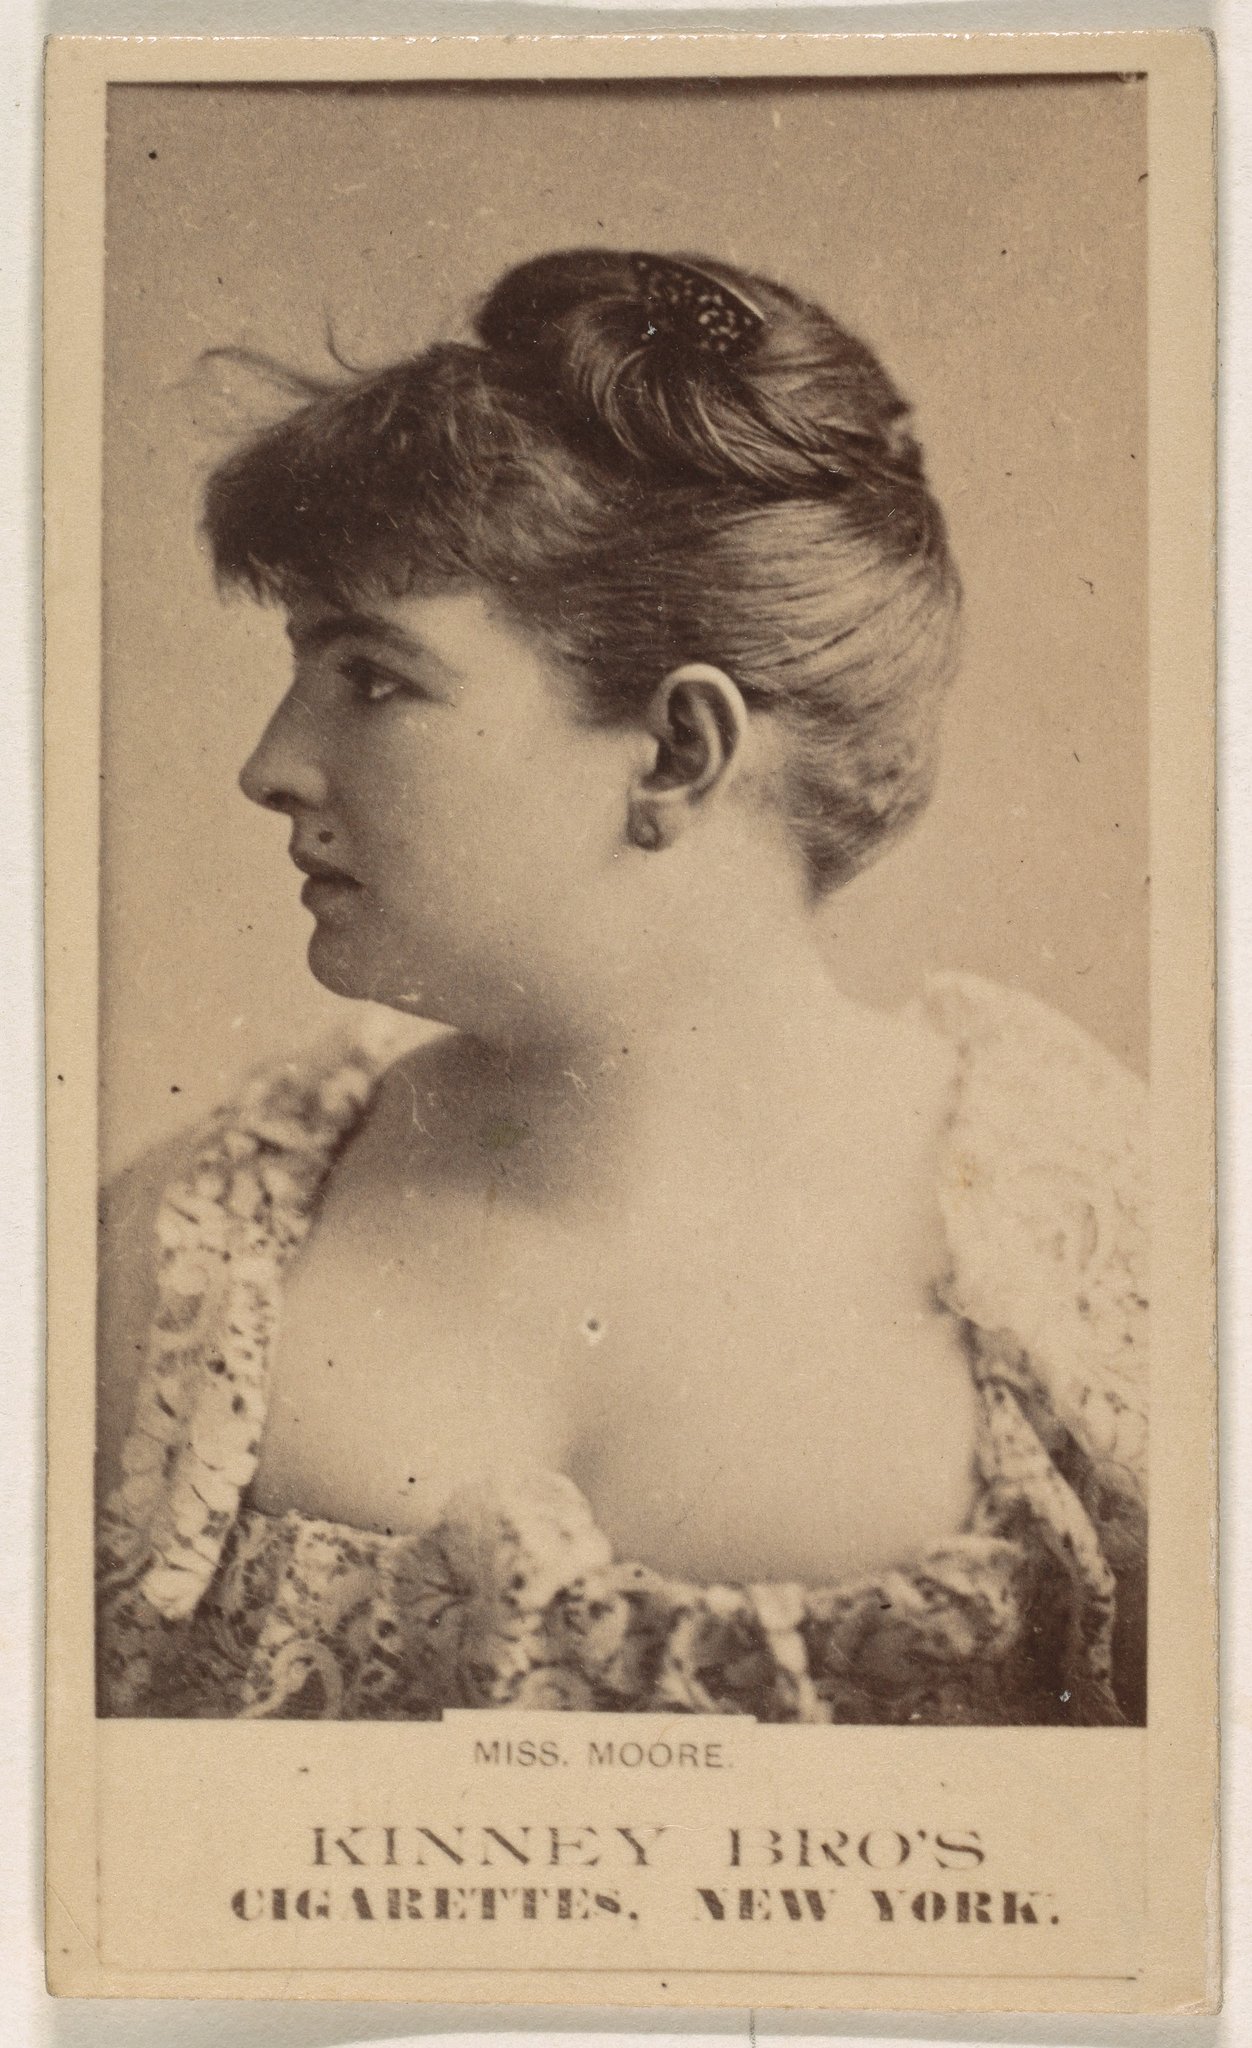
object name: photograph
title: Miss Moore, from the Actresses series (N245) issued by Kinney Brothers to promote Sweet Caporal Cigarettes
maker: kinney brothers tobacco company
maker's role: publisher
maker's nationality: american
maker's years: 1869-2011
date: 1890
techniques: albumen silver print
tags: women,actresses